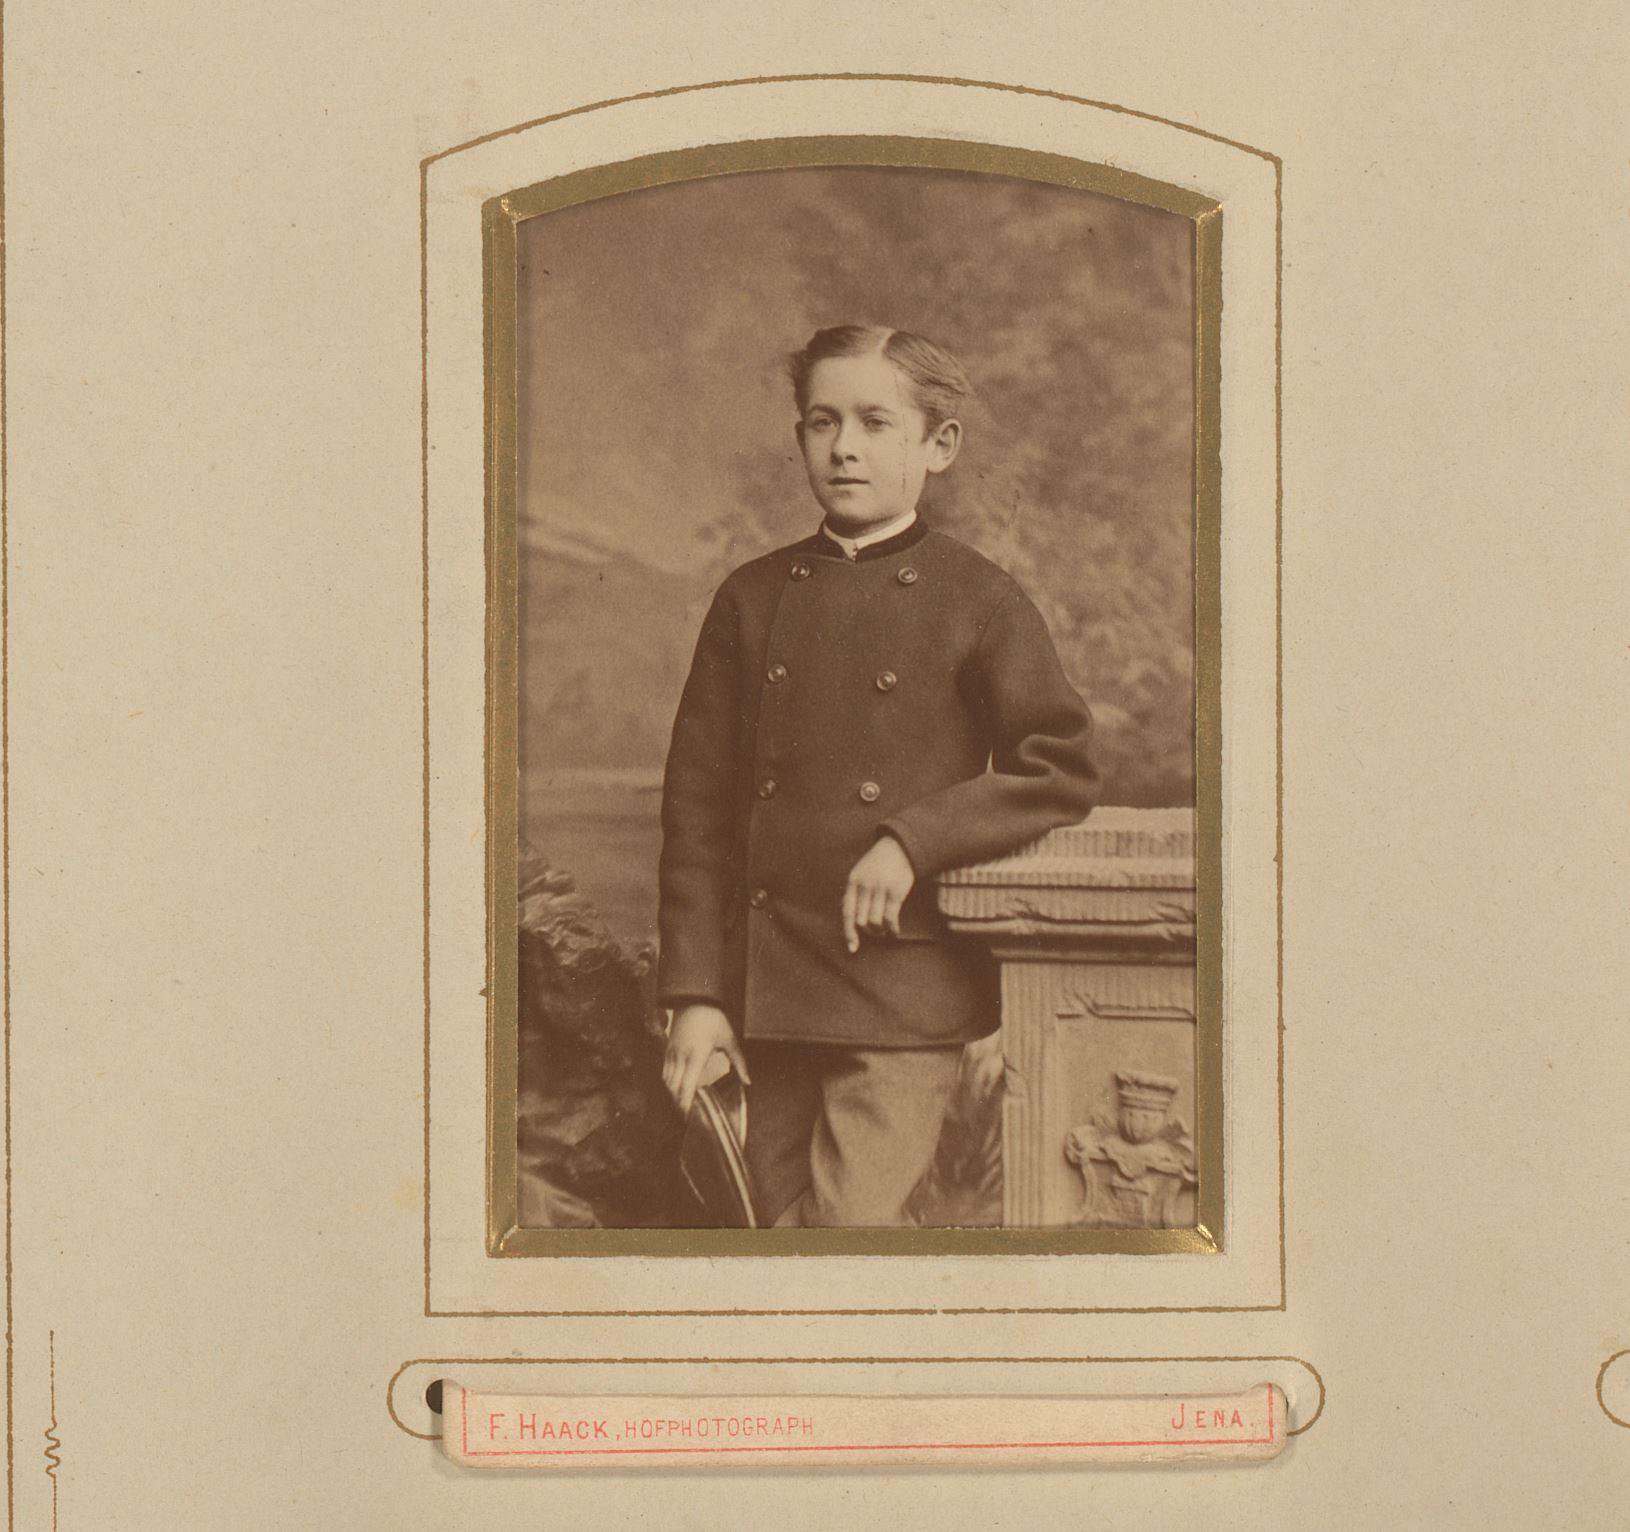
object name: album leaf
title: Portret van een jongen, leunend op een balustrade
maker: friedrich haack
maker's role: fotograaf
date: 1879-1900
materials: cardboard, photographic support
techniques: albumen print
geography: jena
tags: boy (child between toddler and youth), historical persons, balustrade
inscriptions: inscription: ‘Friedrich Haack/ Grossherzogl. Sächs. Hofphotograph/ PRÄMIIRT : LEIPZIG 1879./ Jena/ an der Promenade/ neben dem Gymnasium./ Für Nachbestellungen bleibt die Platte aufbewahrt.’